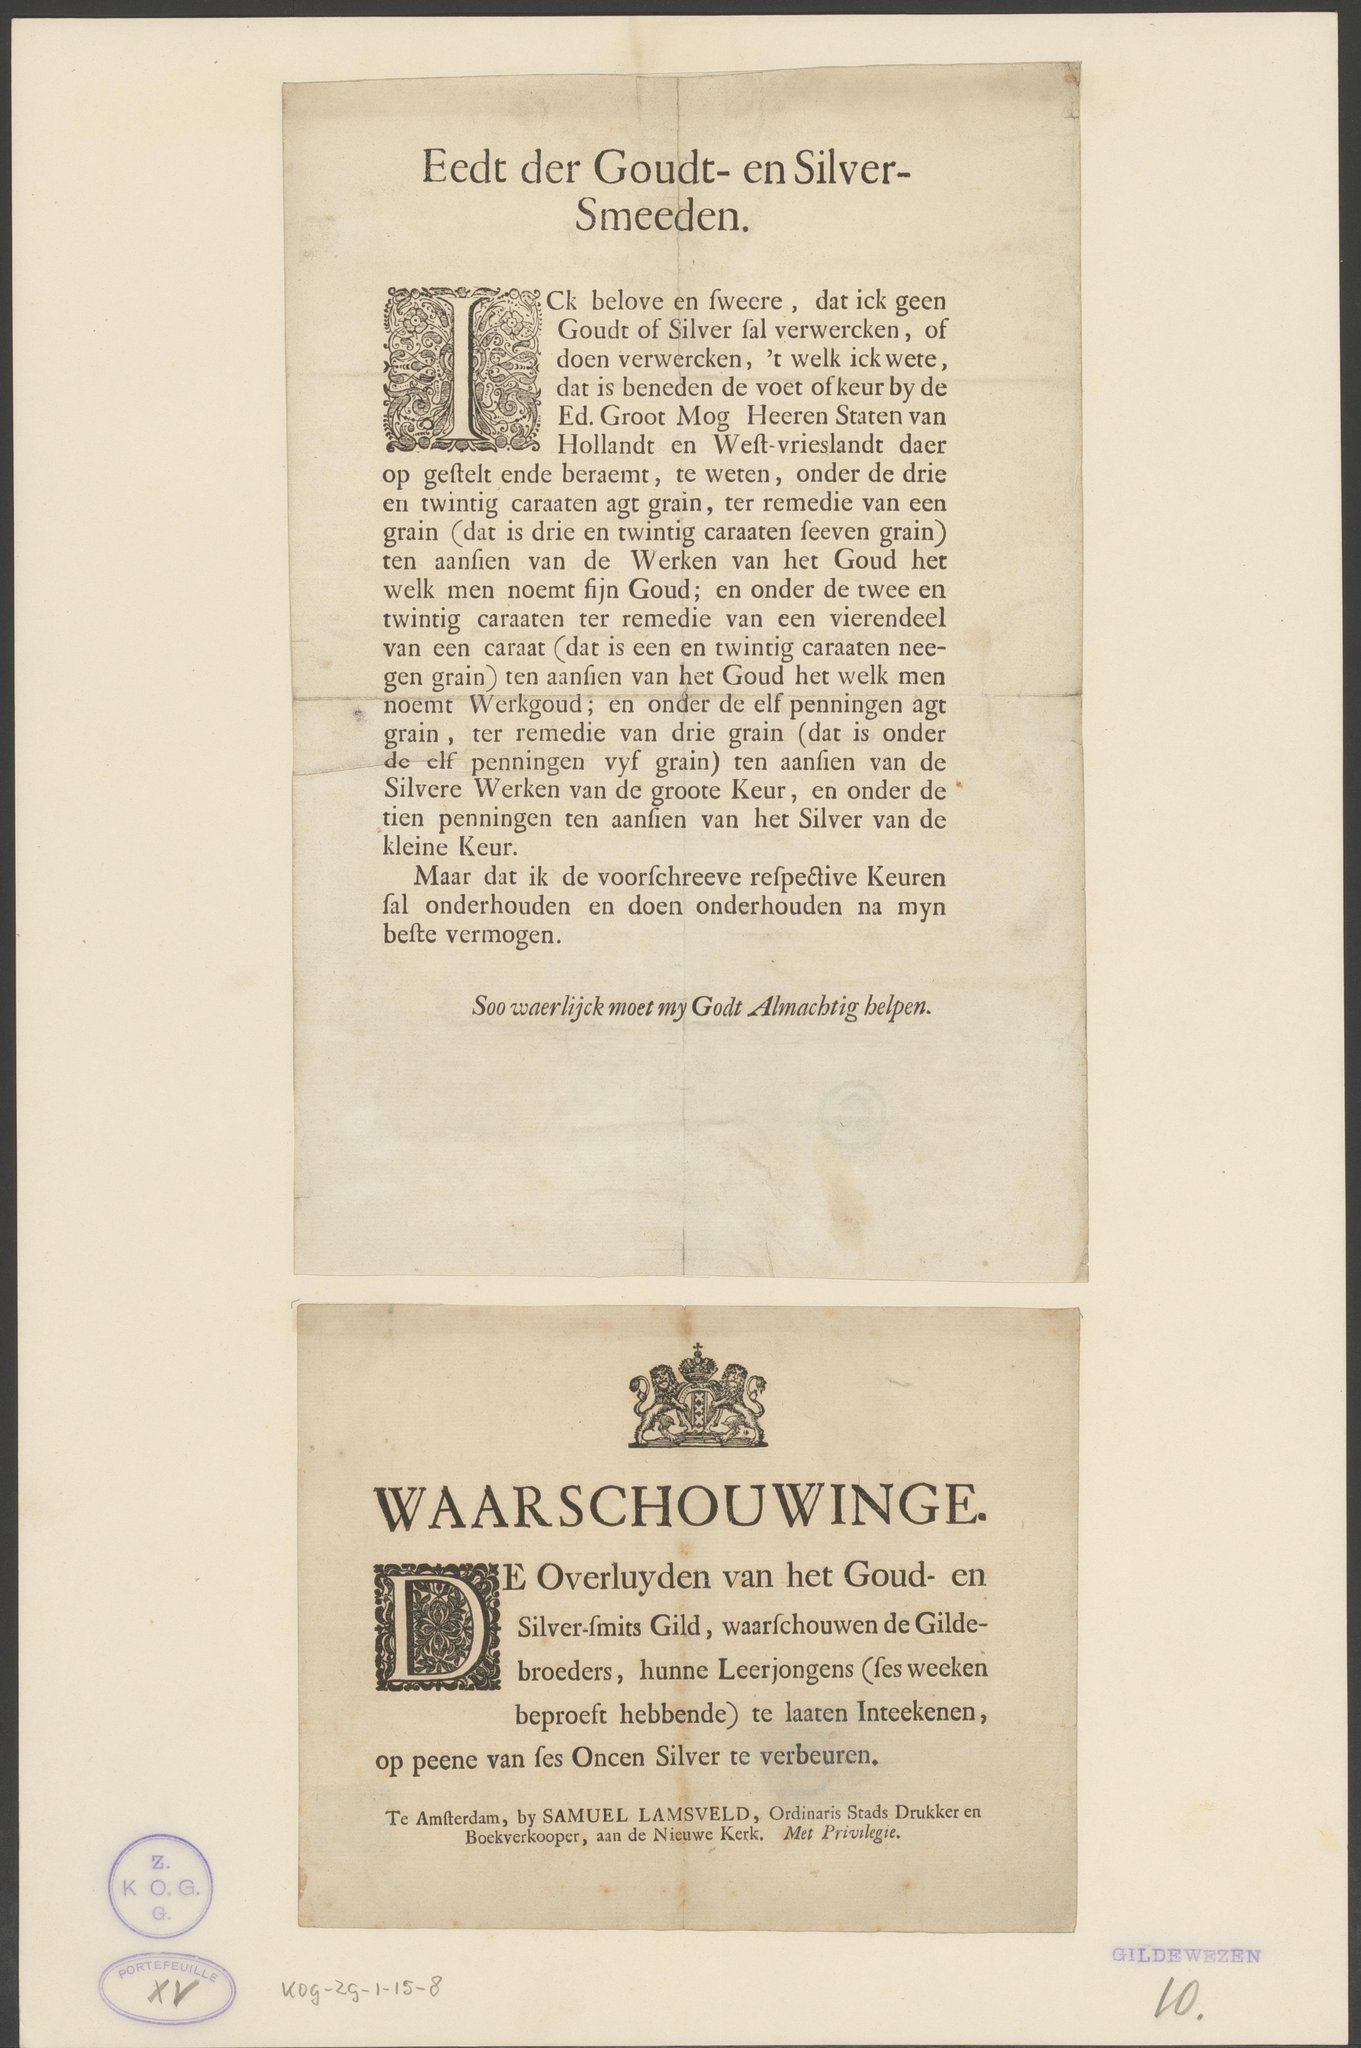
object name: text sheet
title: Eed en waarschuwing van het Goud- en Zilversmeedgilde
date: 1725-1765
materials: paper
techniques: letterpress printing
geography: amsterdam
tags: corporative organization, guild, control of quality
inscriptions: collector's mark: Lugt 1641a, stamp:, collector's mark: Lugt 1641, stamp:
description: Twee tekstbladen. Boven de eed der Goud- en Zilversmeden. Onder een waarschuwing dat leerlingen ingeschreven moeten worden bij het goud- en zilversmeed gilde. Onderwerpsrubrieken binnen de Atlas Zeden en Gewoonten: Handel, nijverheid en verkeer, Gildewezen.